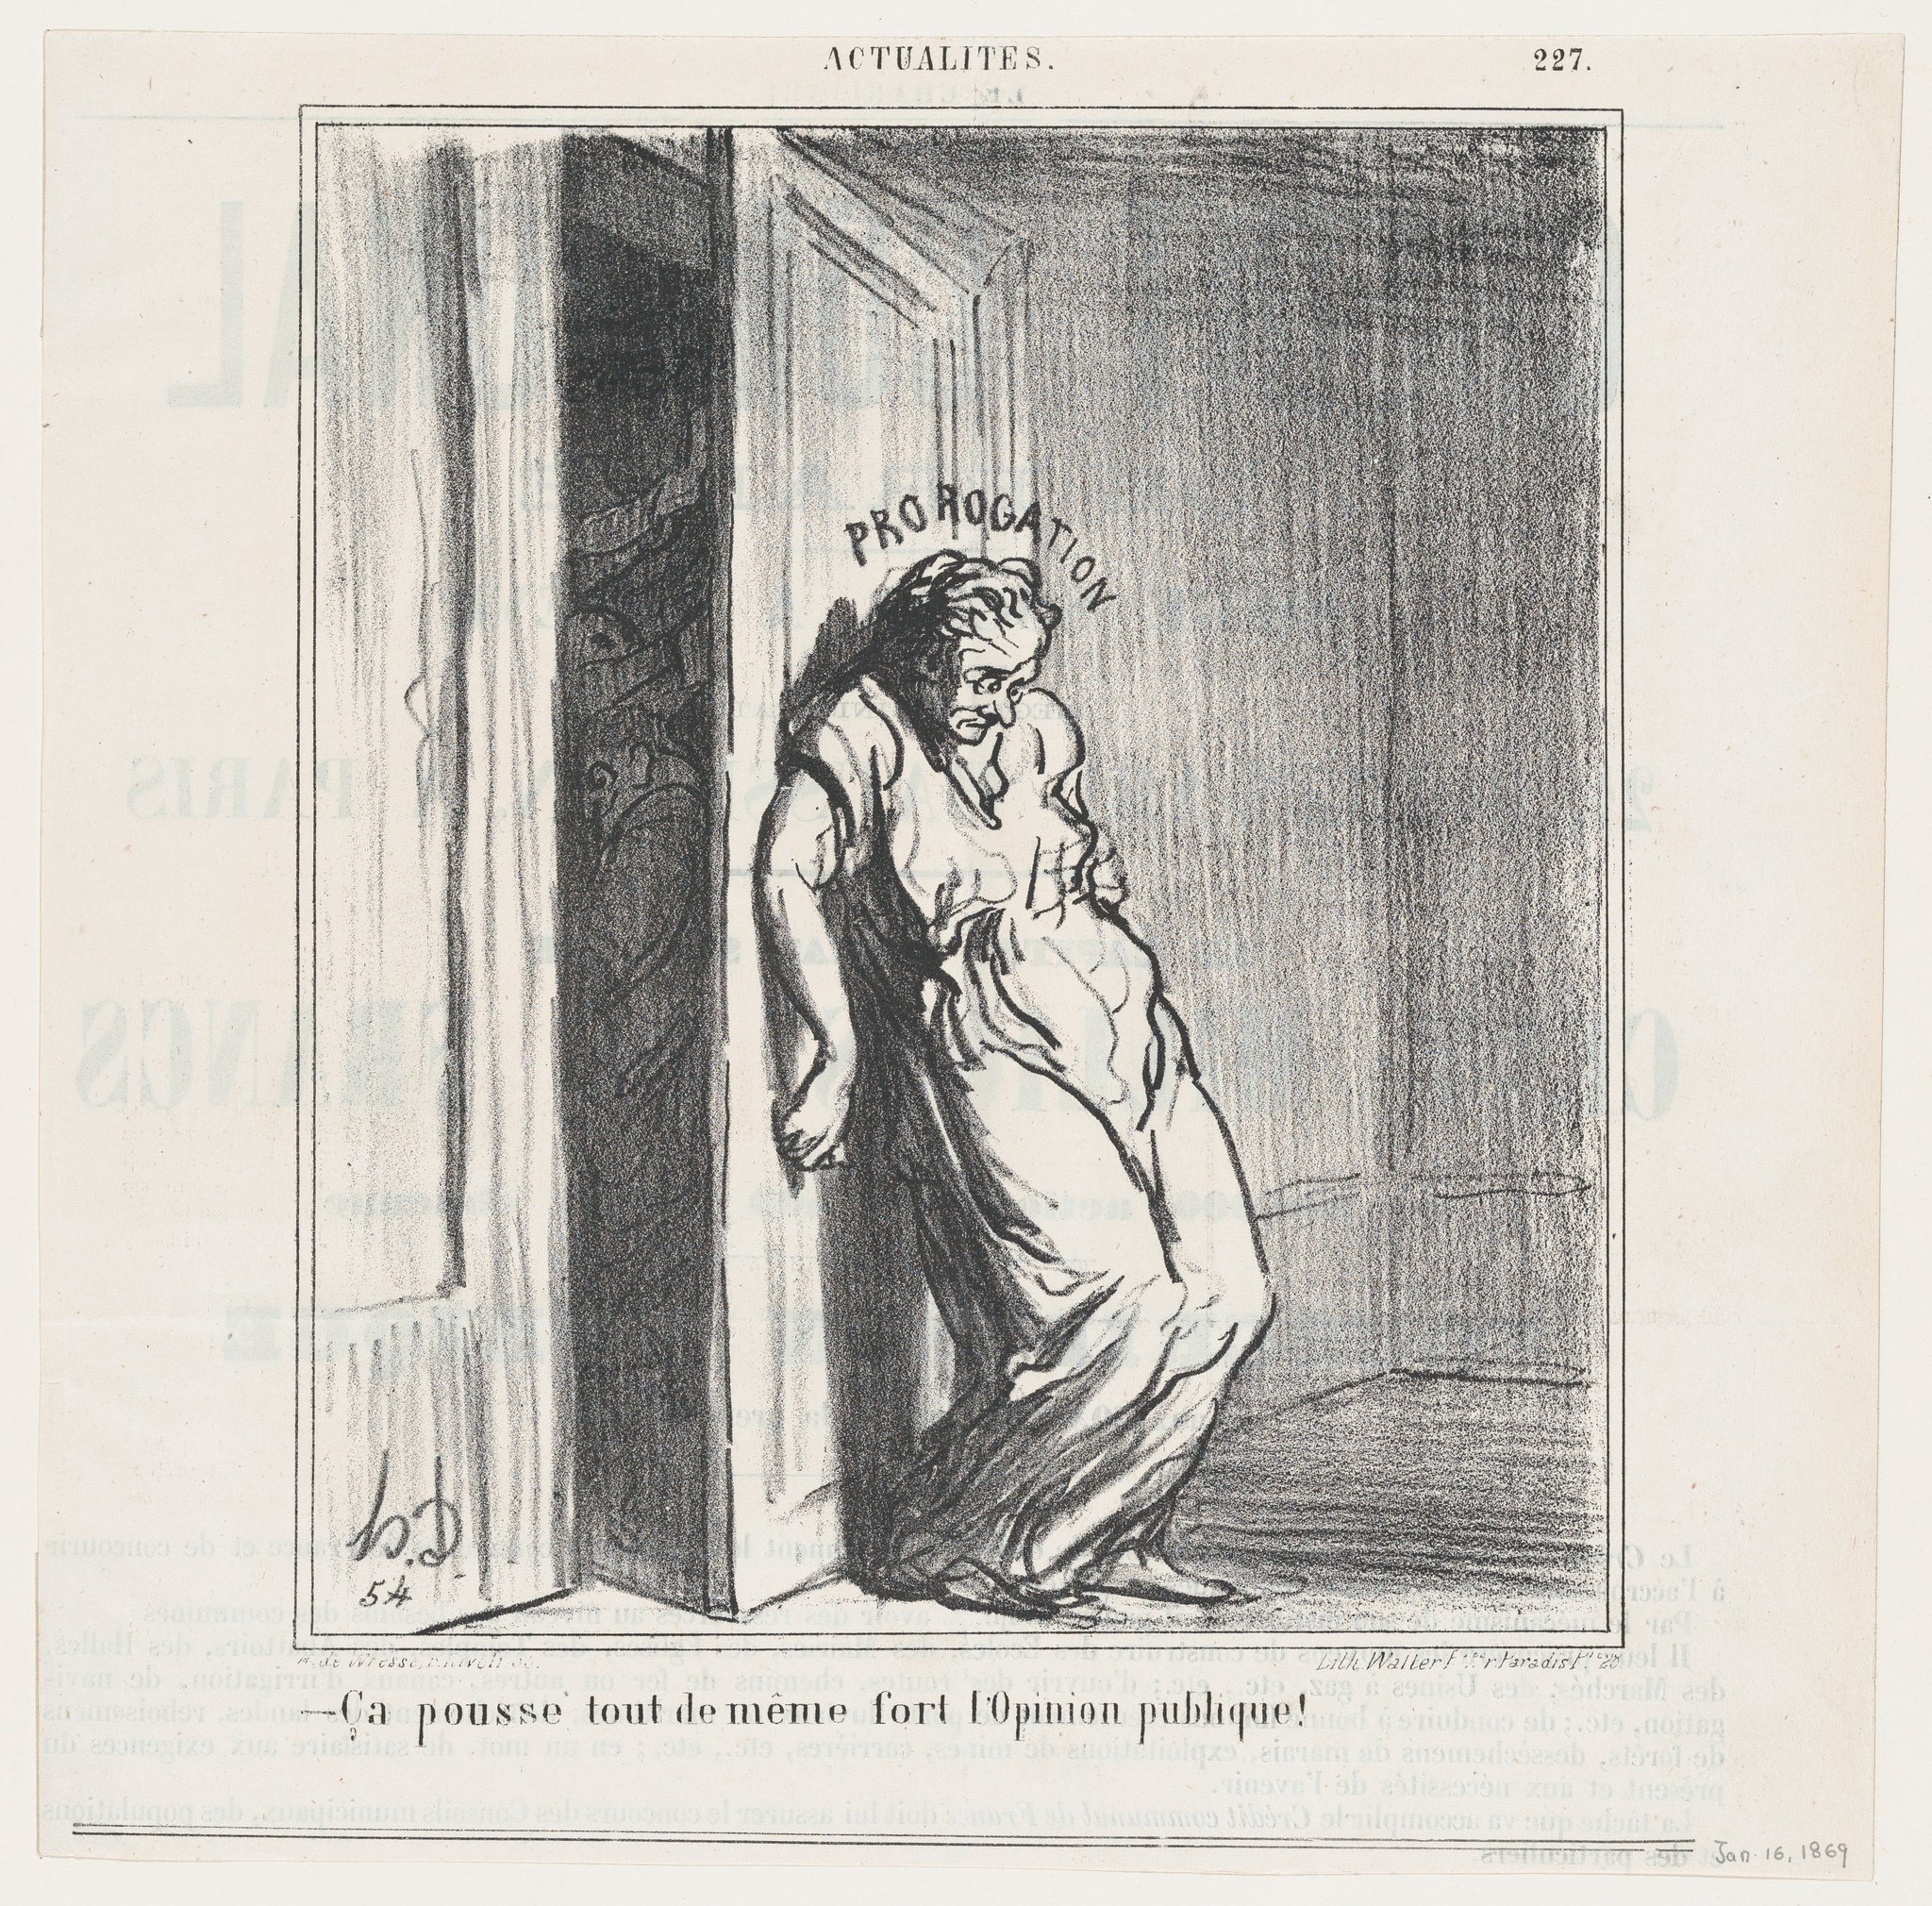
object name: print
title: After all, public opinion is really pushing hard, from 'News of the day,' published in Le Charivari, January 16, 1869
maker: honoré daumier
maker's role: artist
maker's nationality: french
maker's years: 1808-1879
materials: paper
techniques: lithograph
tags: satire,doors,women